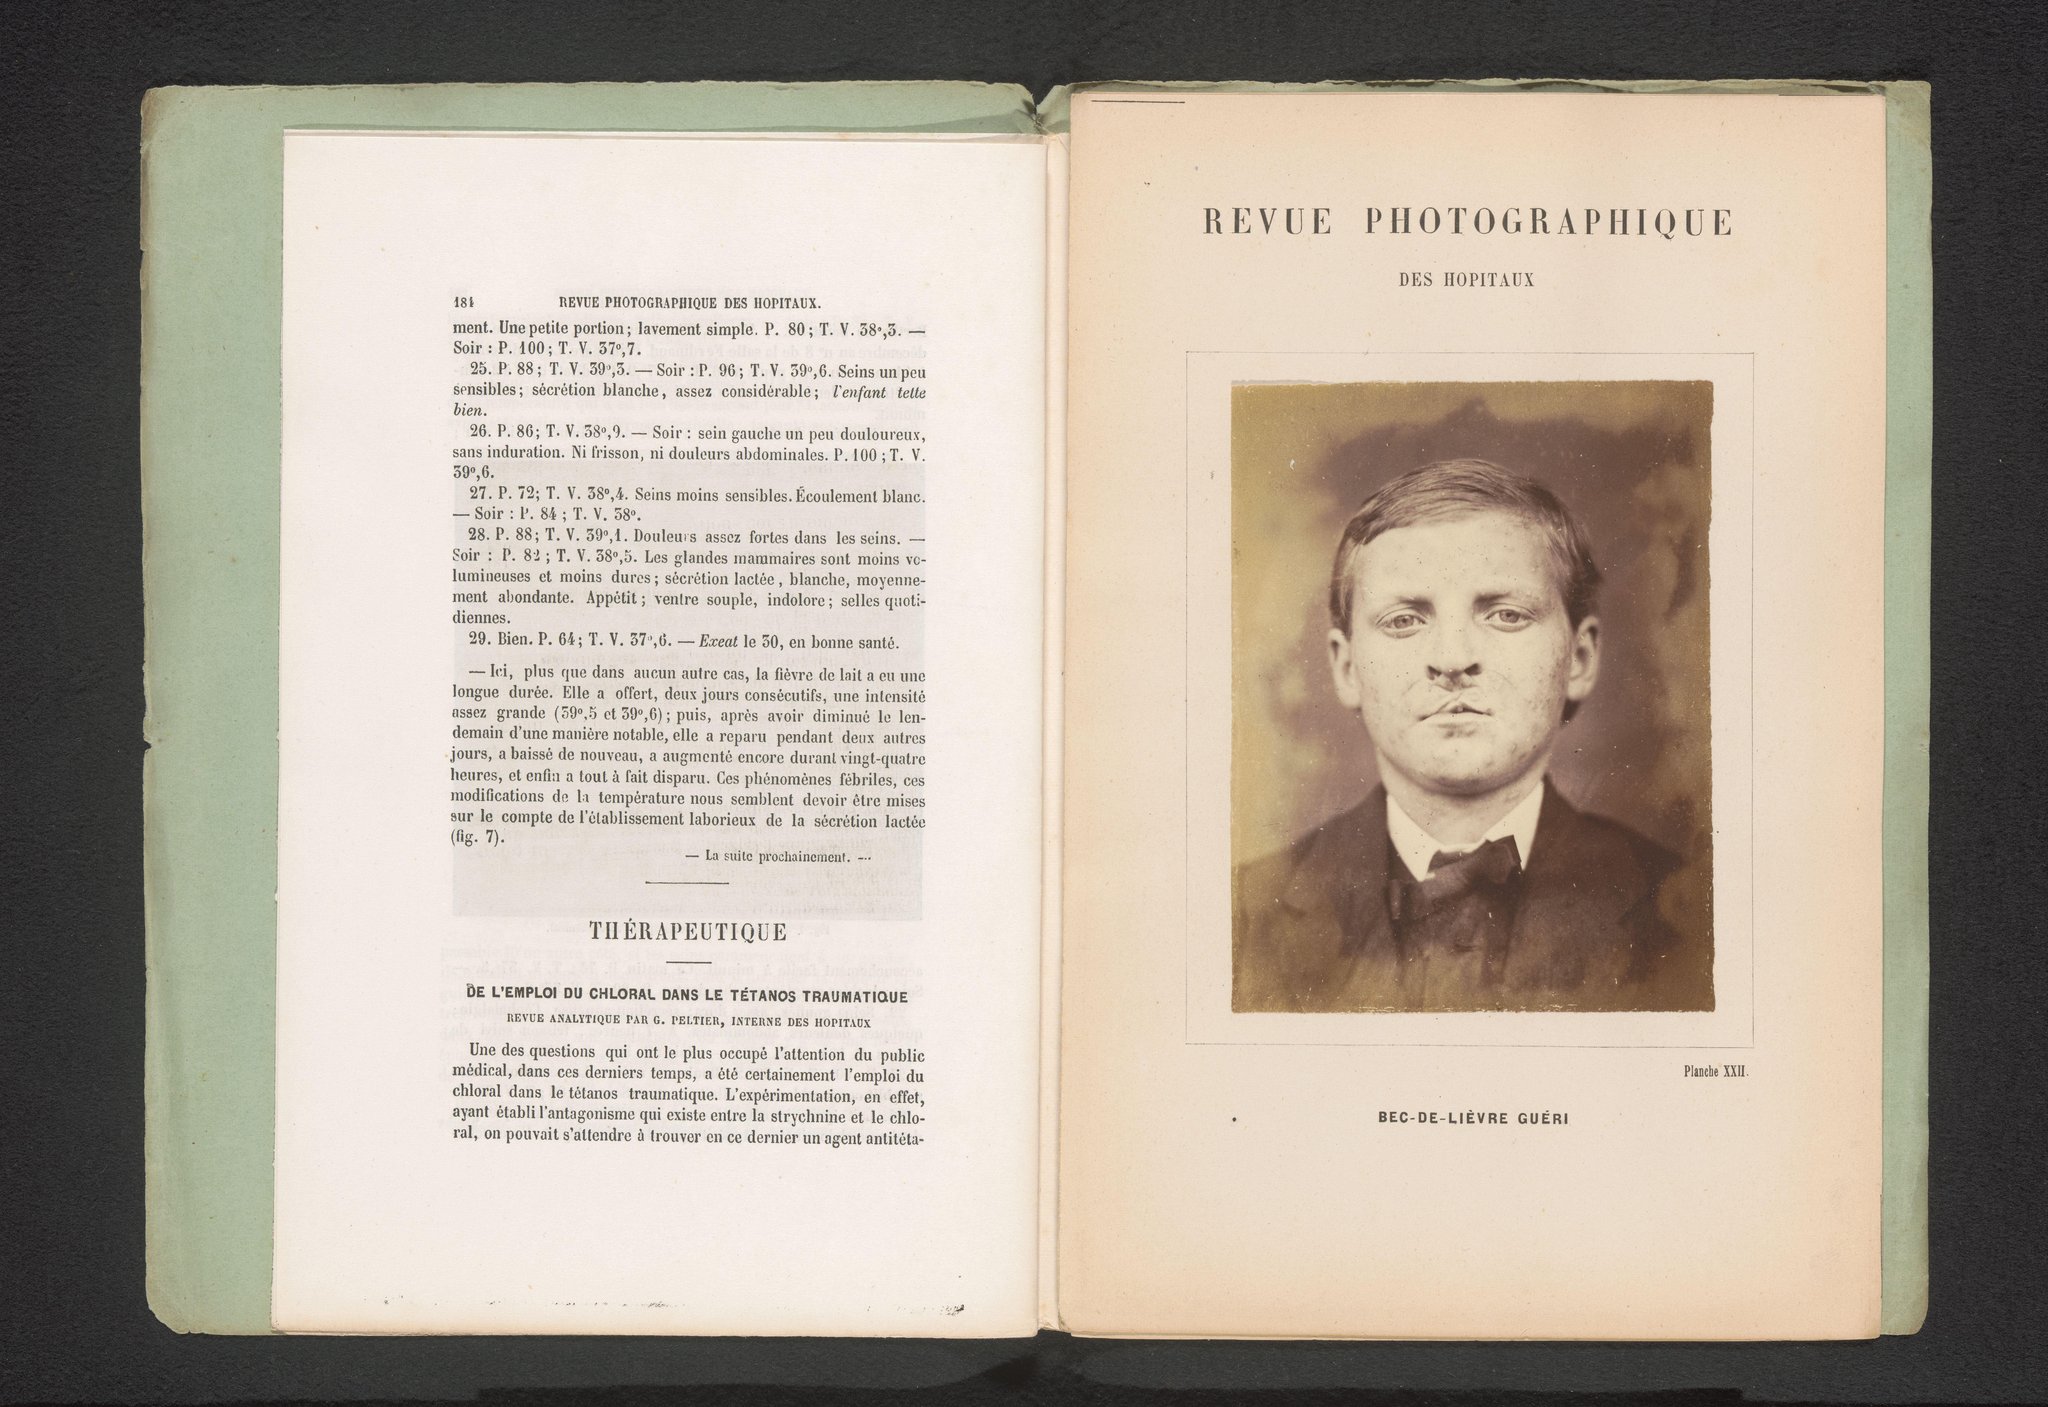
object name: photograph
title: Portret van een onbekende jongen met een hazenlip na een operatie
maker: Anonymous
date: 1865-1870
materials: paper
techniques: albumen print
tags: hare-lip, historical persons, youth, adolescent, medical research, branches of medicine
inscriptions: inscription: ‘Revue photographique/ des hopitaux/ Planche XXII.’